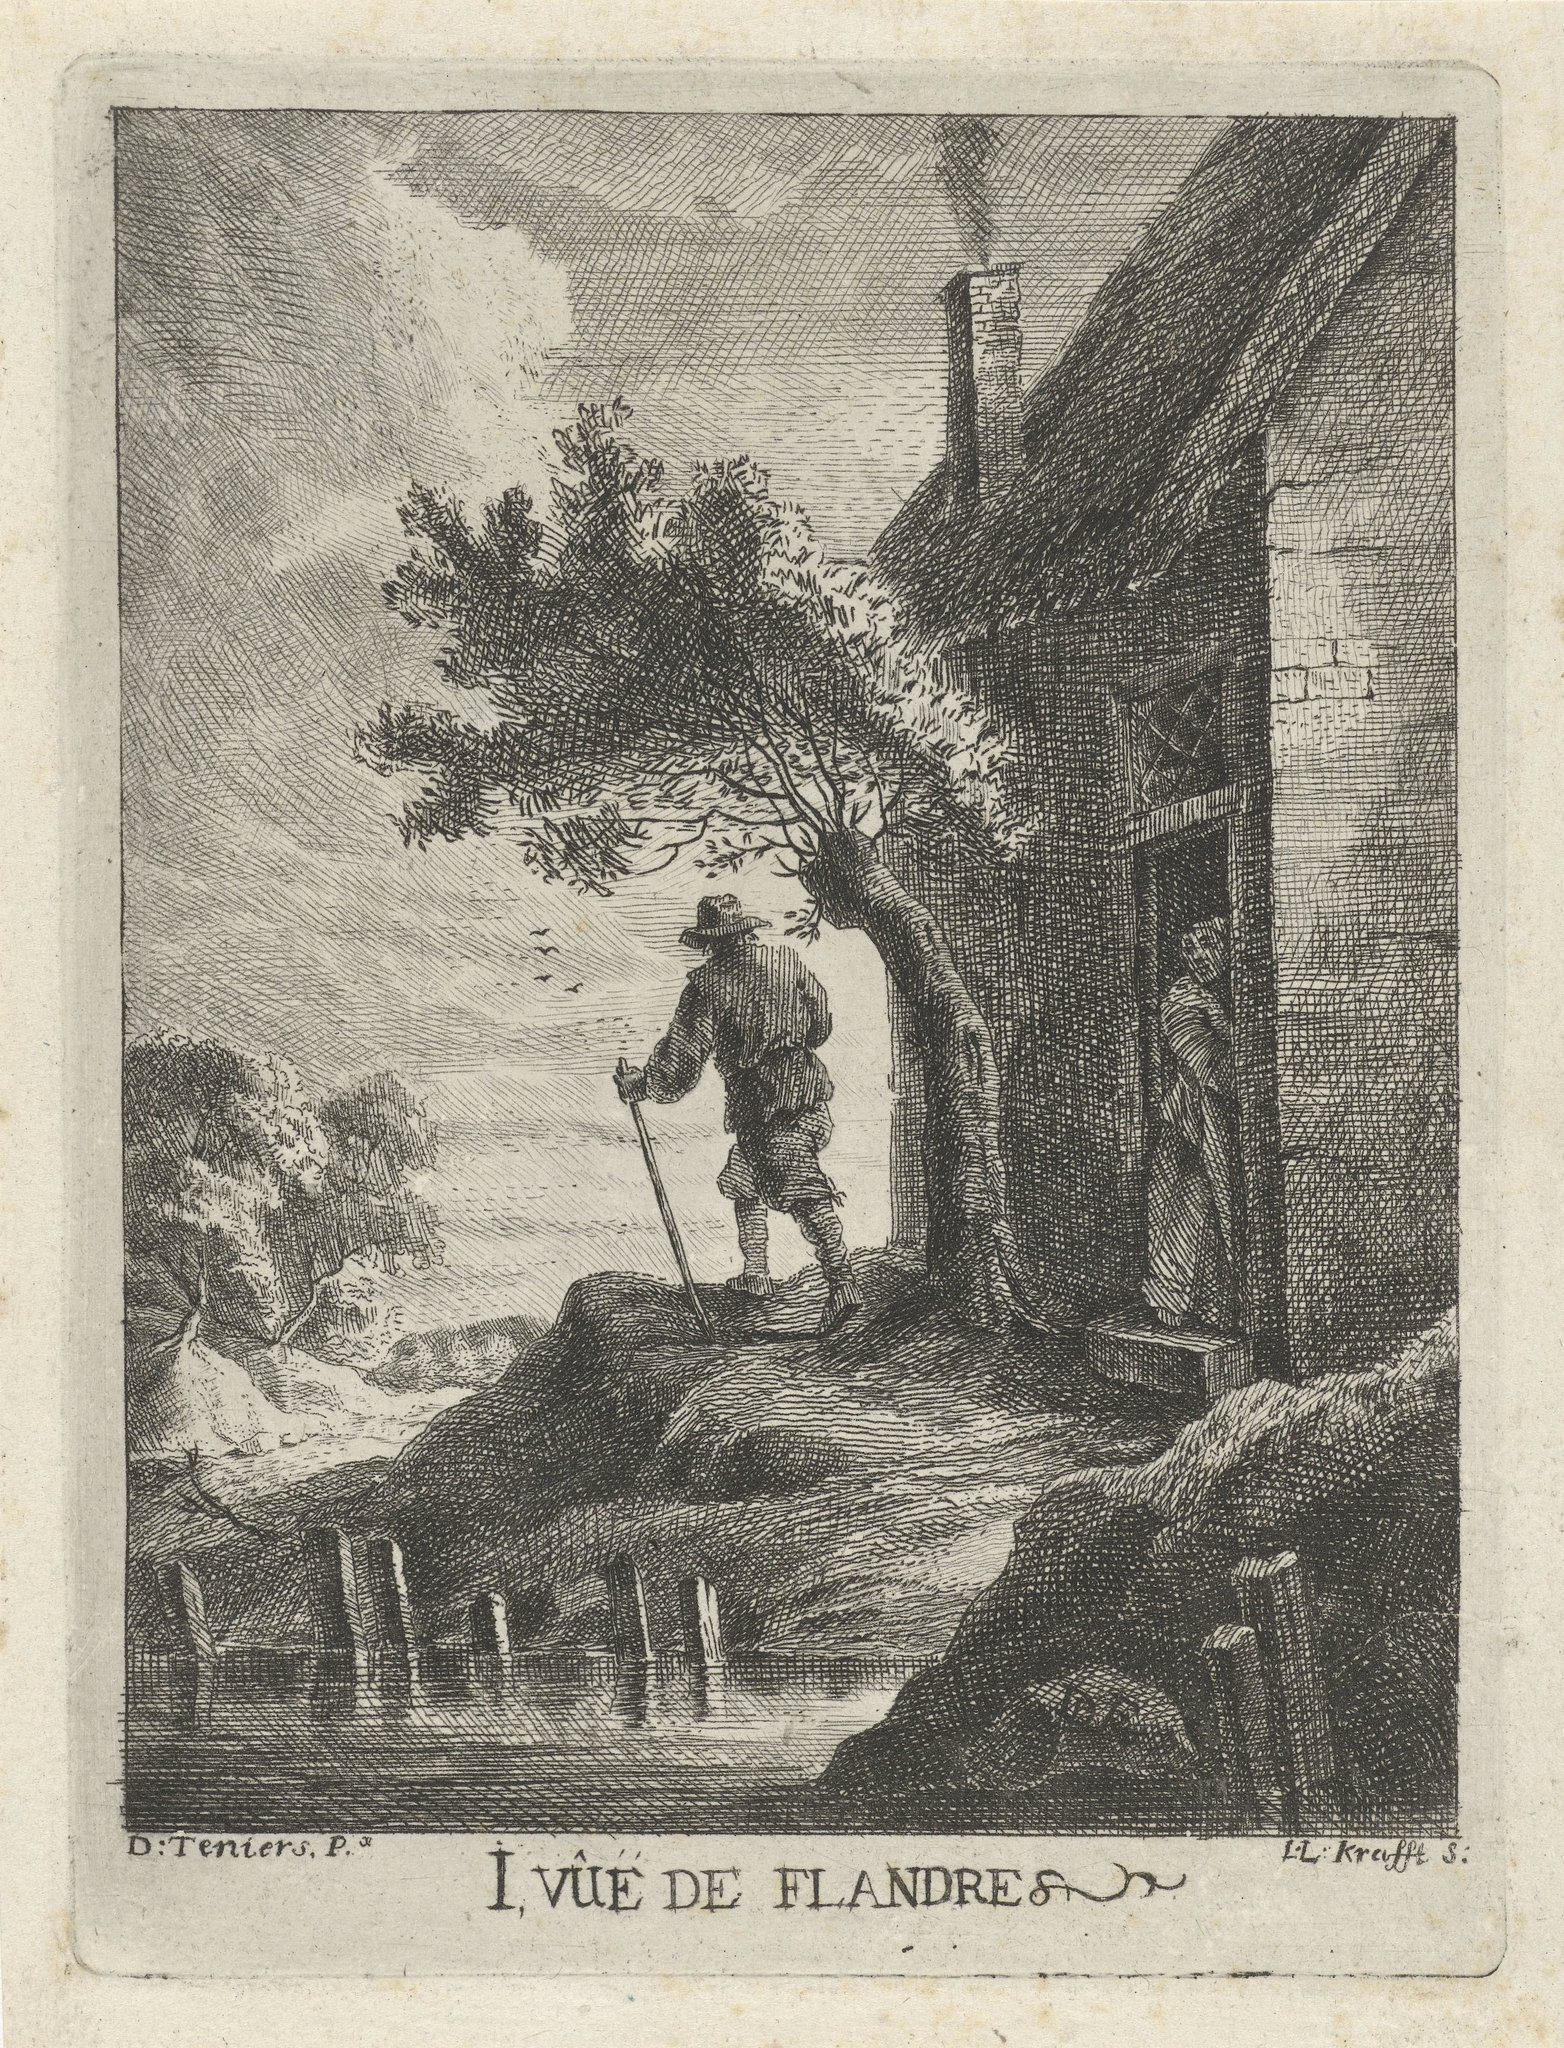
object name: print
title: Boerenwoning aan de waterkant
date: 1704-1764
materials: paper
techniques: etching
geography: southern netherlands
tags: low hill country, rural housing, e.g. country-house, villa, cottage, trees: willow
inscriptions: collector's mark: Lugt 2228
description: In de deuropening van een boerenhuis staat een vrouw te kijken naar een man met wandelstok. De woning ligt aan het water. De prent maakt deel uit van een serie met Vlaamse landschappen.